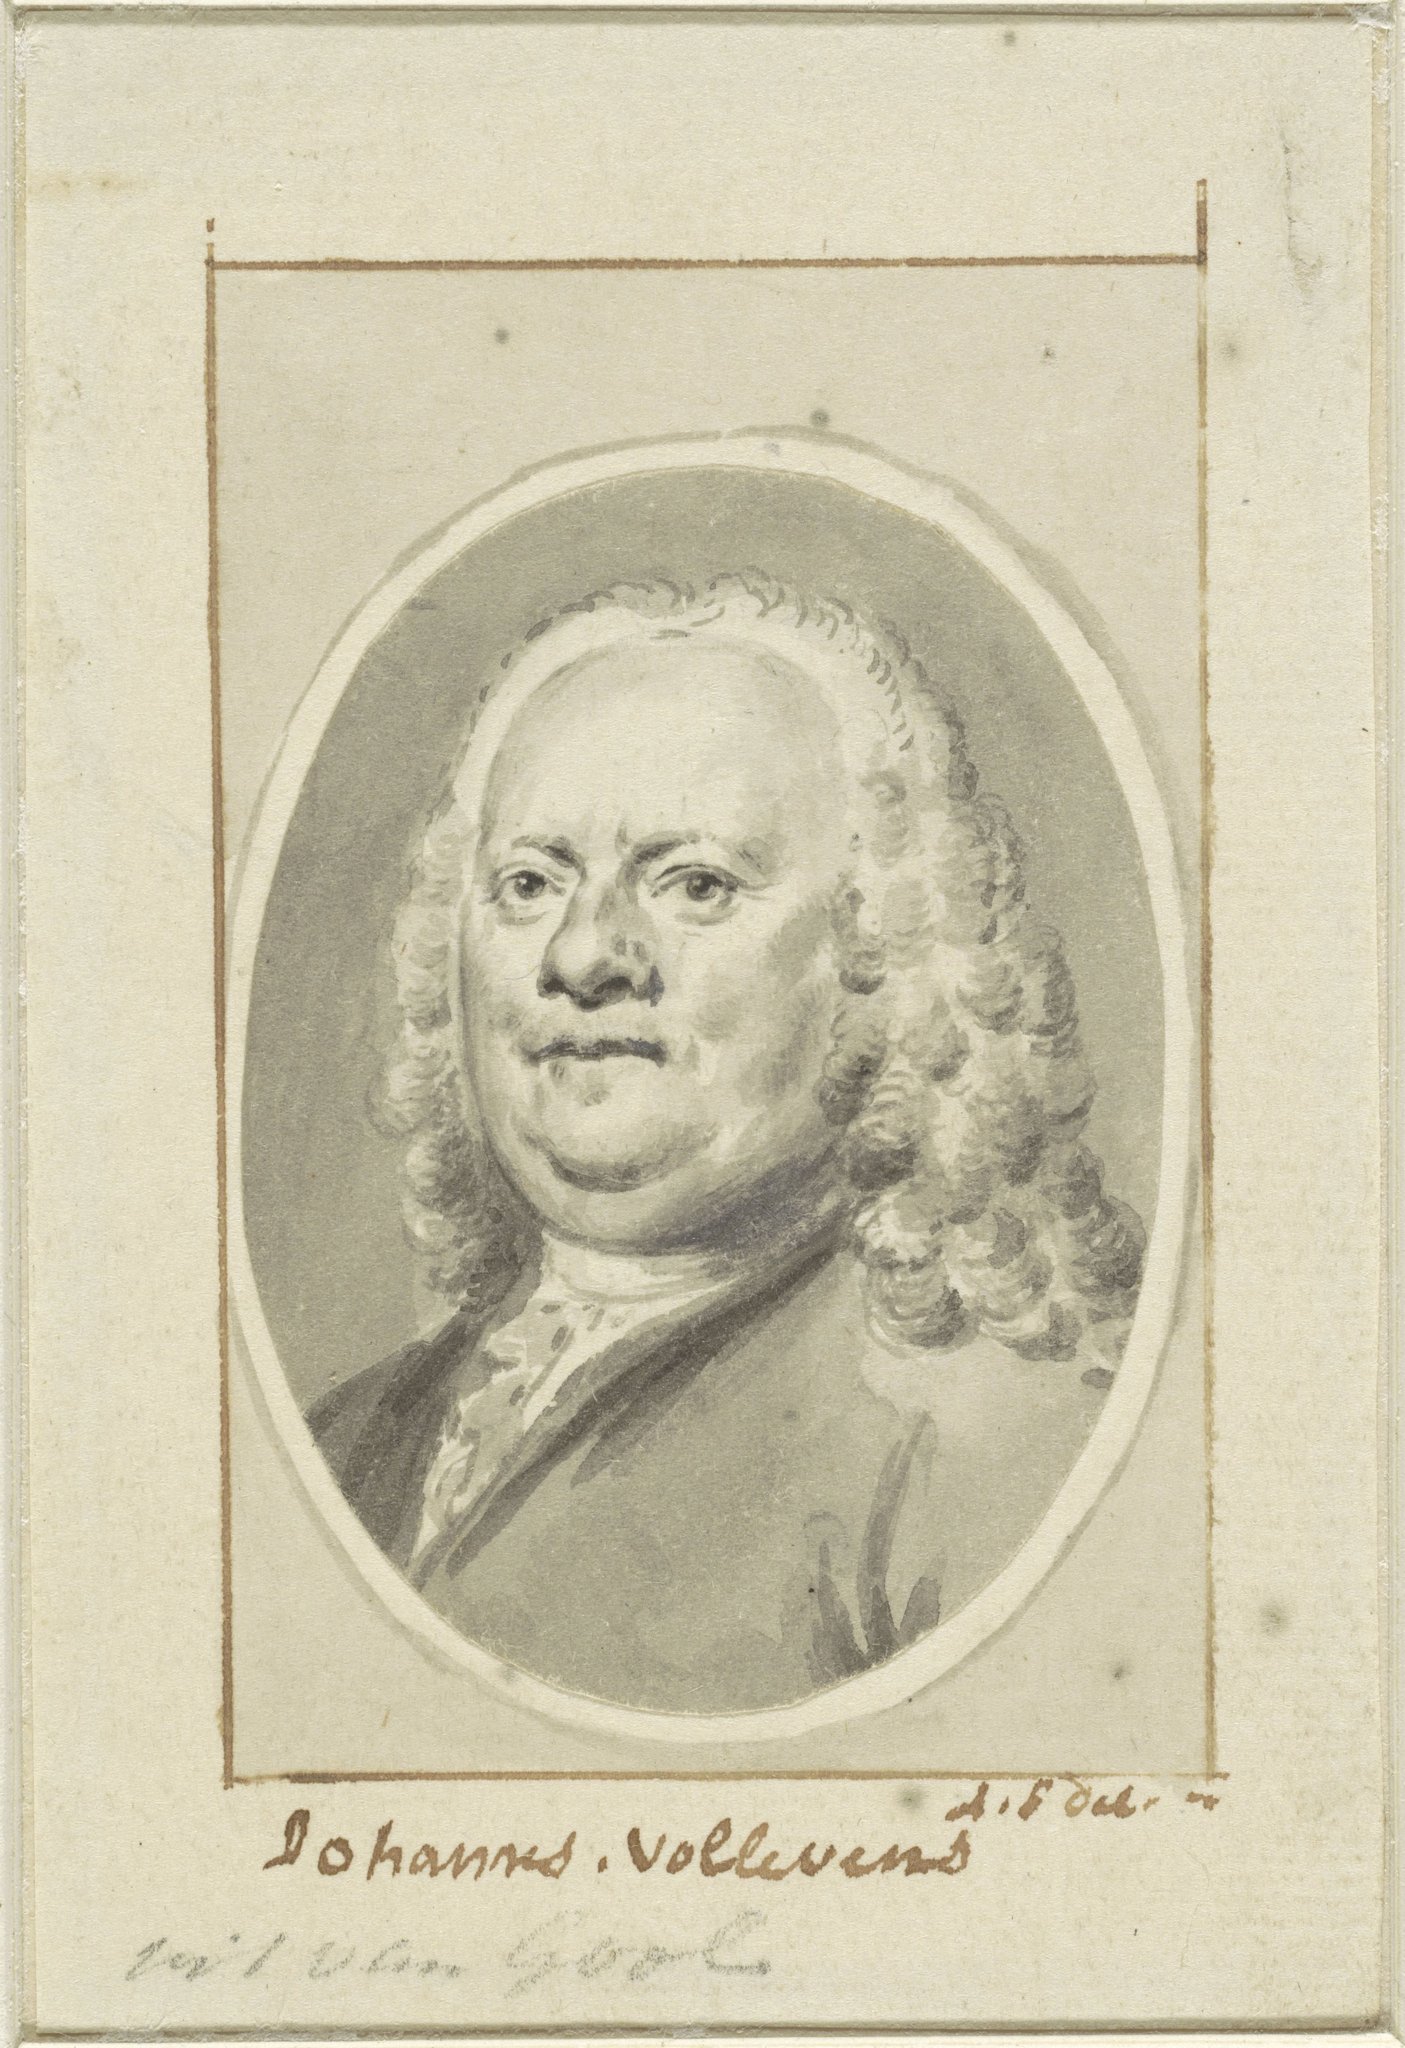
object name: drawing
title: Portret van Johannes Vollevens (II)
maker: aert schouman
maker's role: draughtsman, painter, print maker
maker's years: 1710-1792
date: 1720-1792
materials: ink, paper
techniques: brush, pen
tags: johannes vollevens (ii), historical persons, portrait, self-portrait of painter, portrait, self-portrait of artist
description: Portret van de schilder Johannes Vollevens (II).